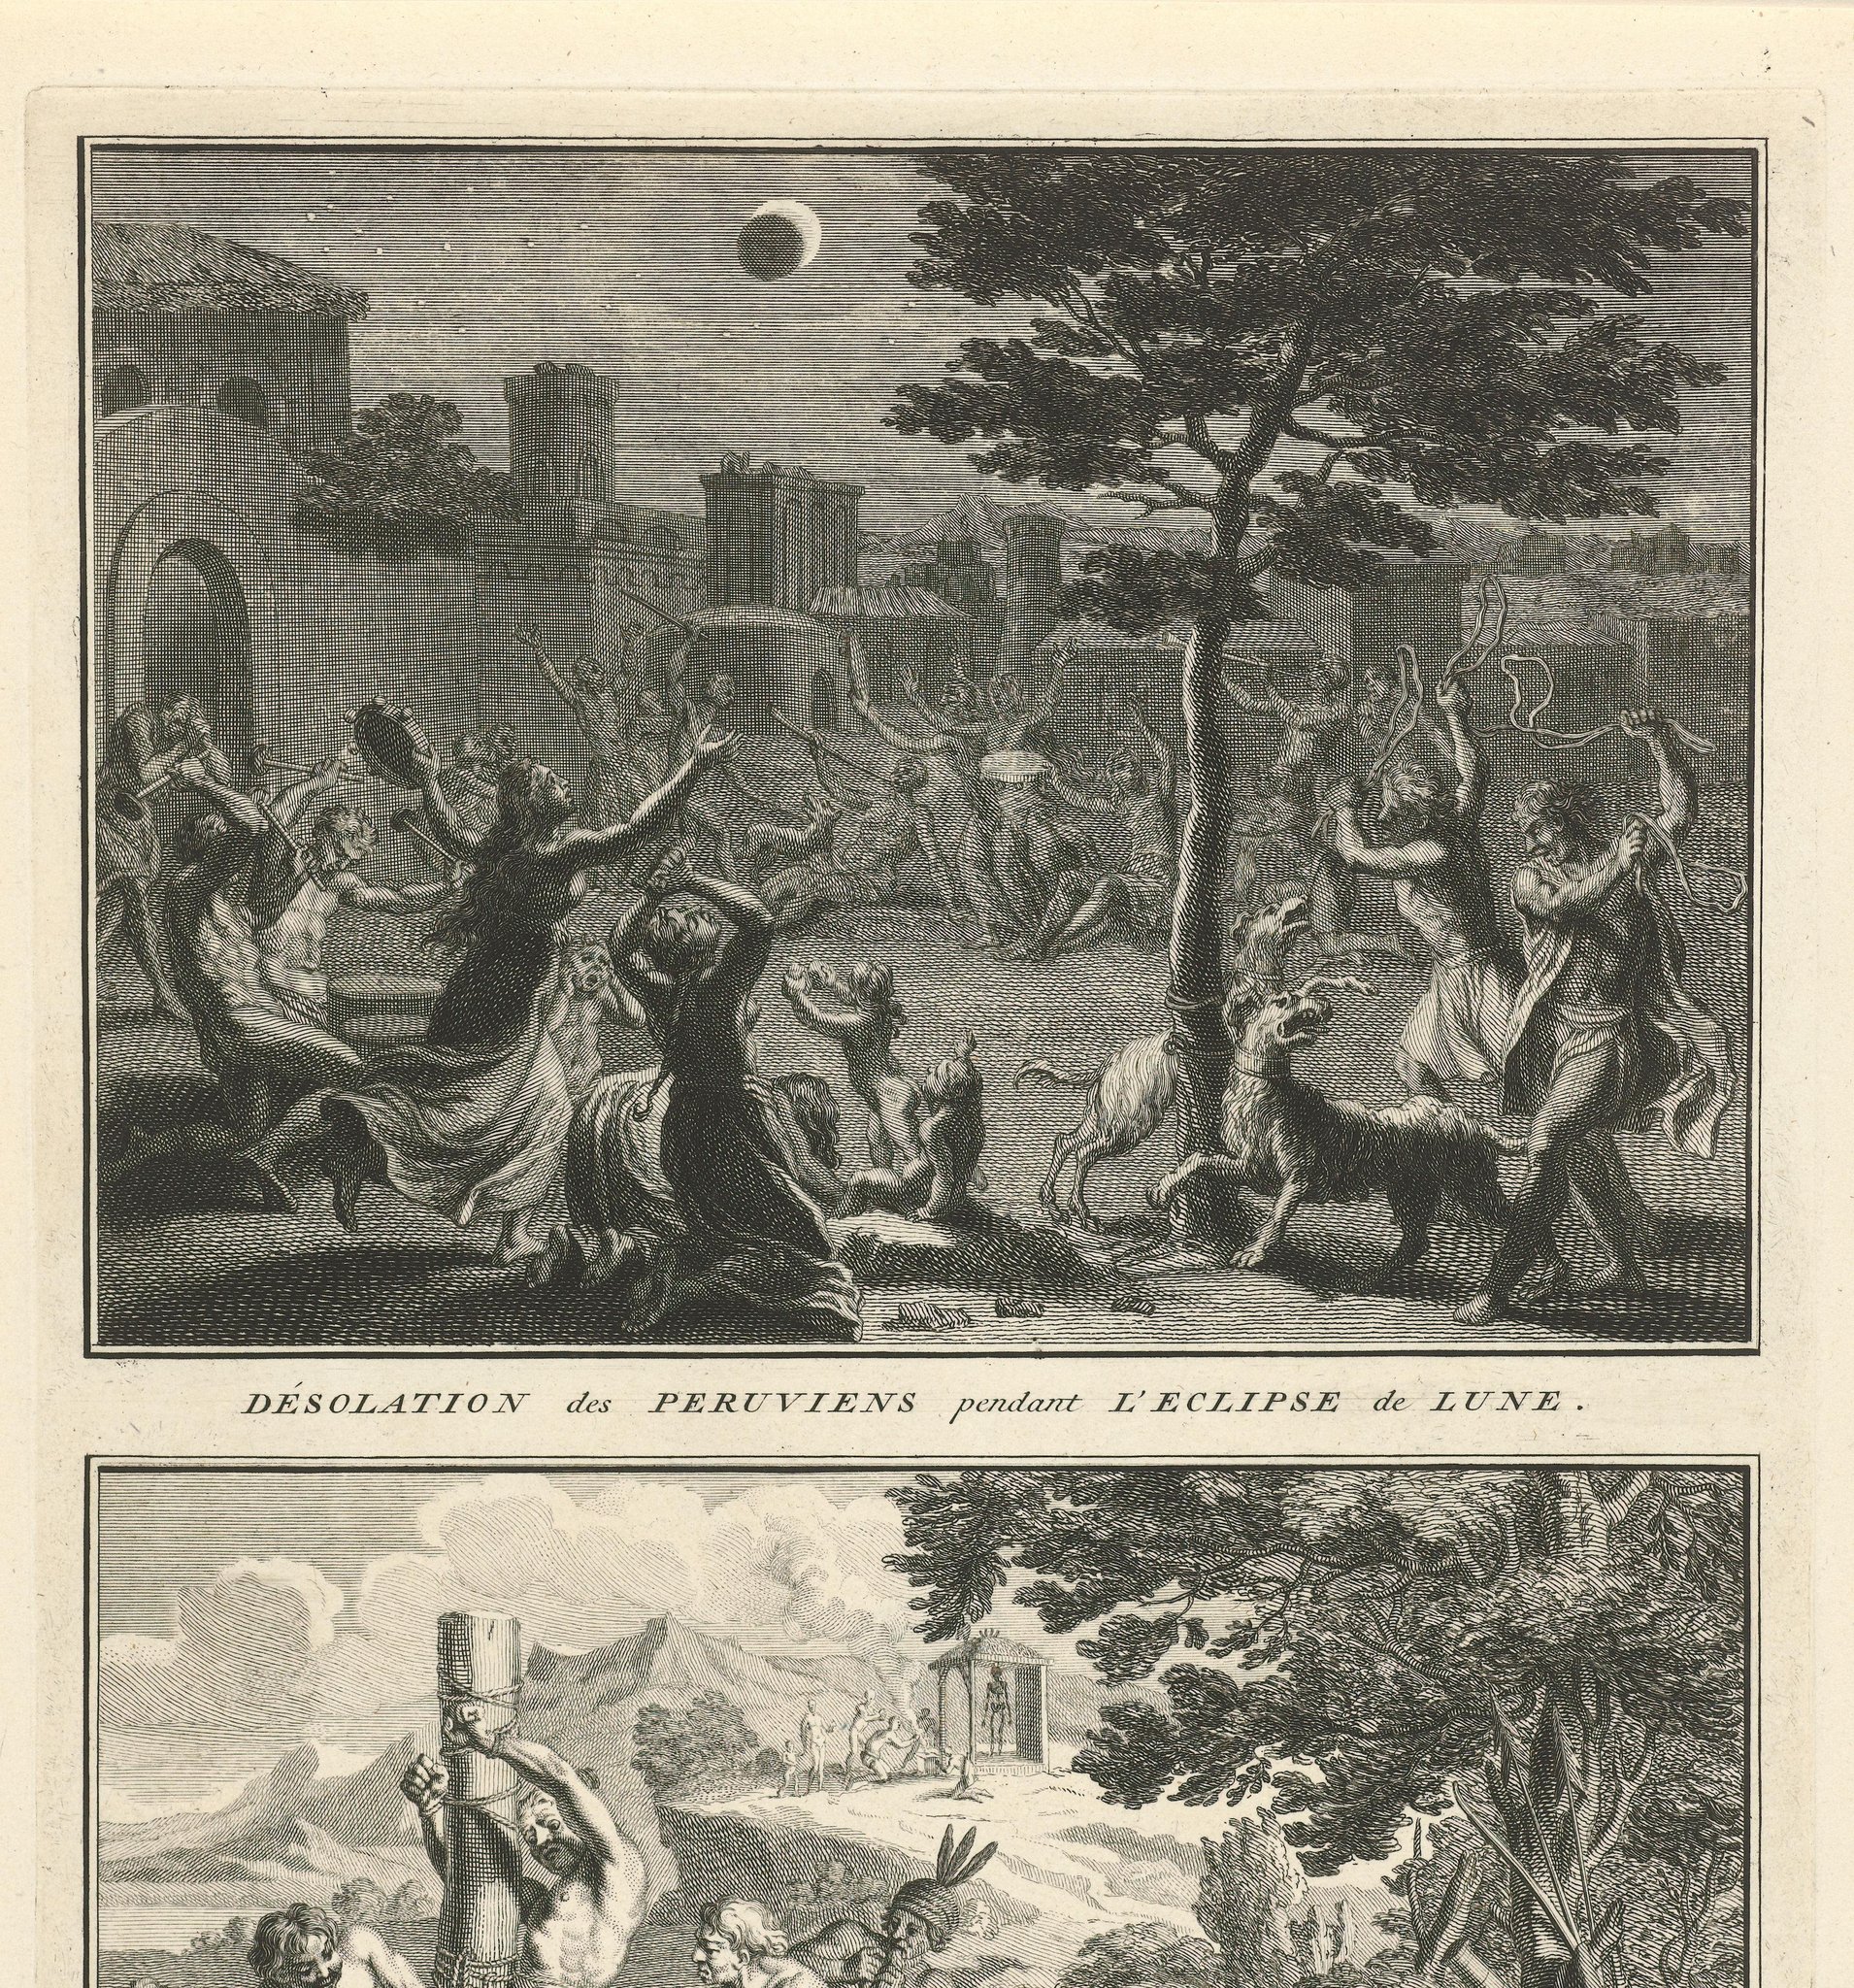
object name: print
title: Voorstellingen van religieuze plechtigheden bij de Inca's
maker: bernard picart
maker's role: draughtsman, print maker, publisher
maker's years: 1673-1733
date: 1723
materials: paper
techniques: engraving, etching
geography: amsterdam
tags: ritual practices ~ american indian religions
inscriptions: collector's mark: Lugt 2228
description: Prent ook gebruikt in: Picart, Bernard. Naaukeurige beschryving der uitwendige godtsdienst-plichten, kerk-zeden en gewoontens van alle volkeren der waereldt, deel III. [Vertaald in het Nederlands door] Moubach, Abraham. Den Haag, Amsterdam, Rotterdam: Rutgert Alberts, Hermannus Uytwerf, Jan Daniel Beman, Isaac van der Kloot, 1727-1738.